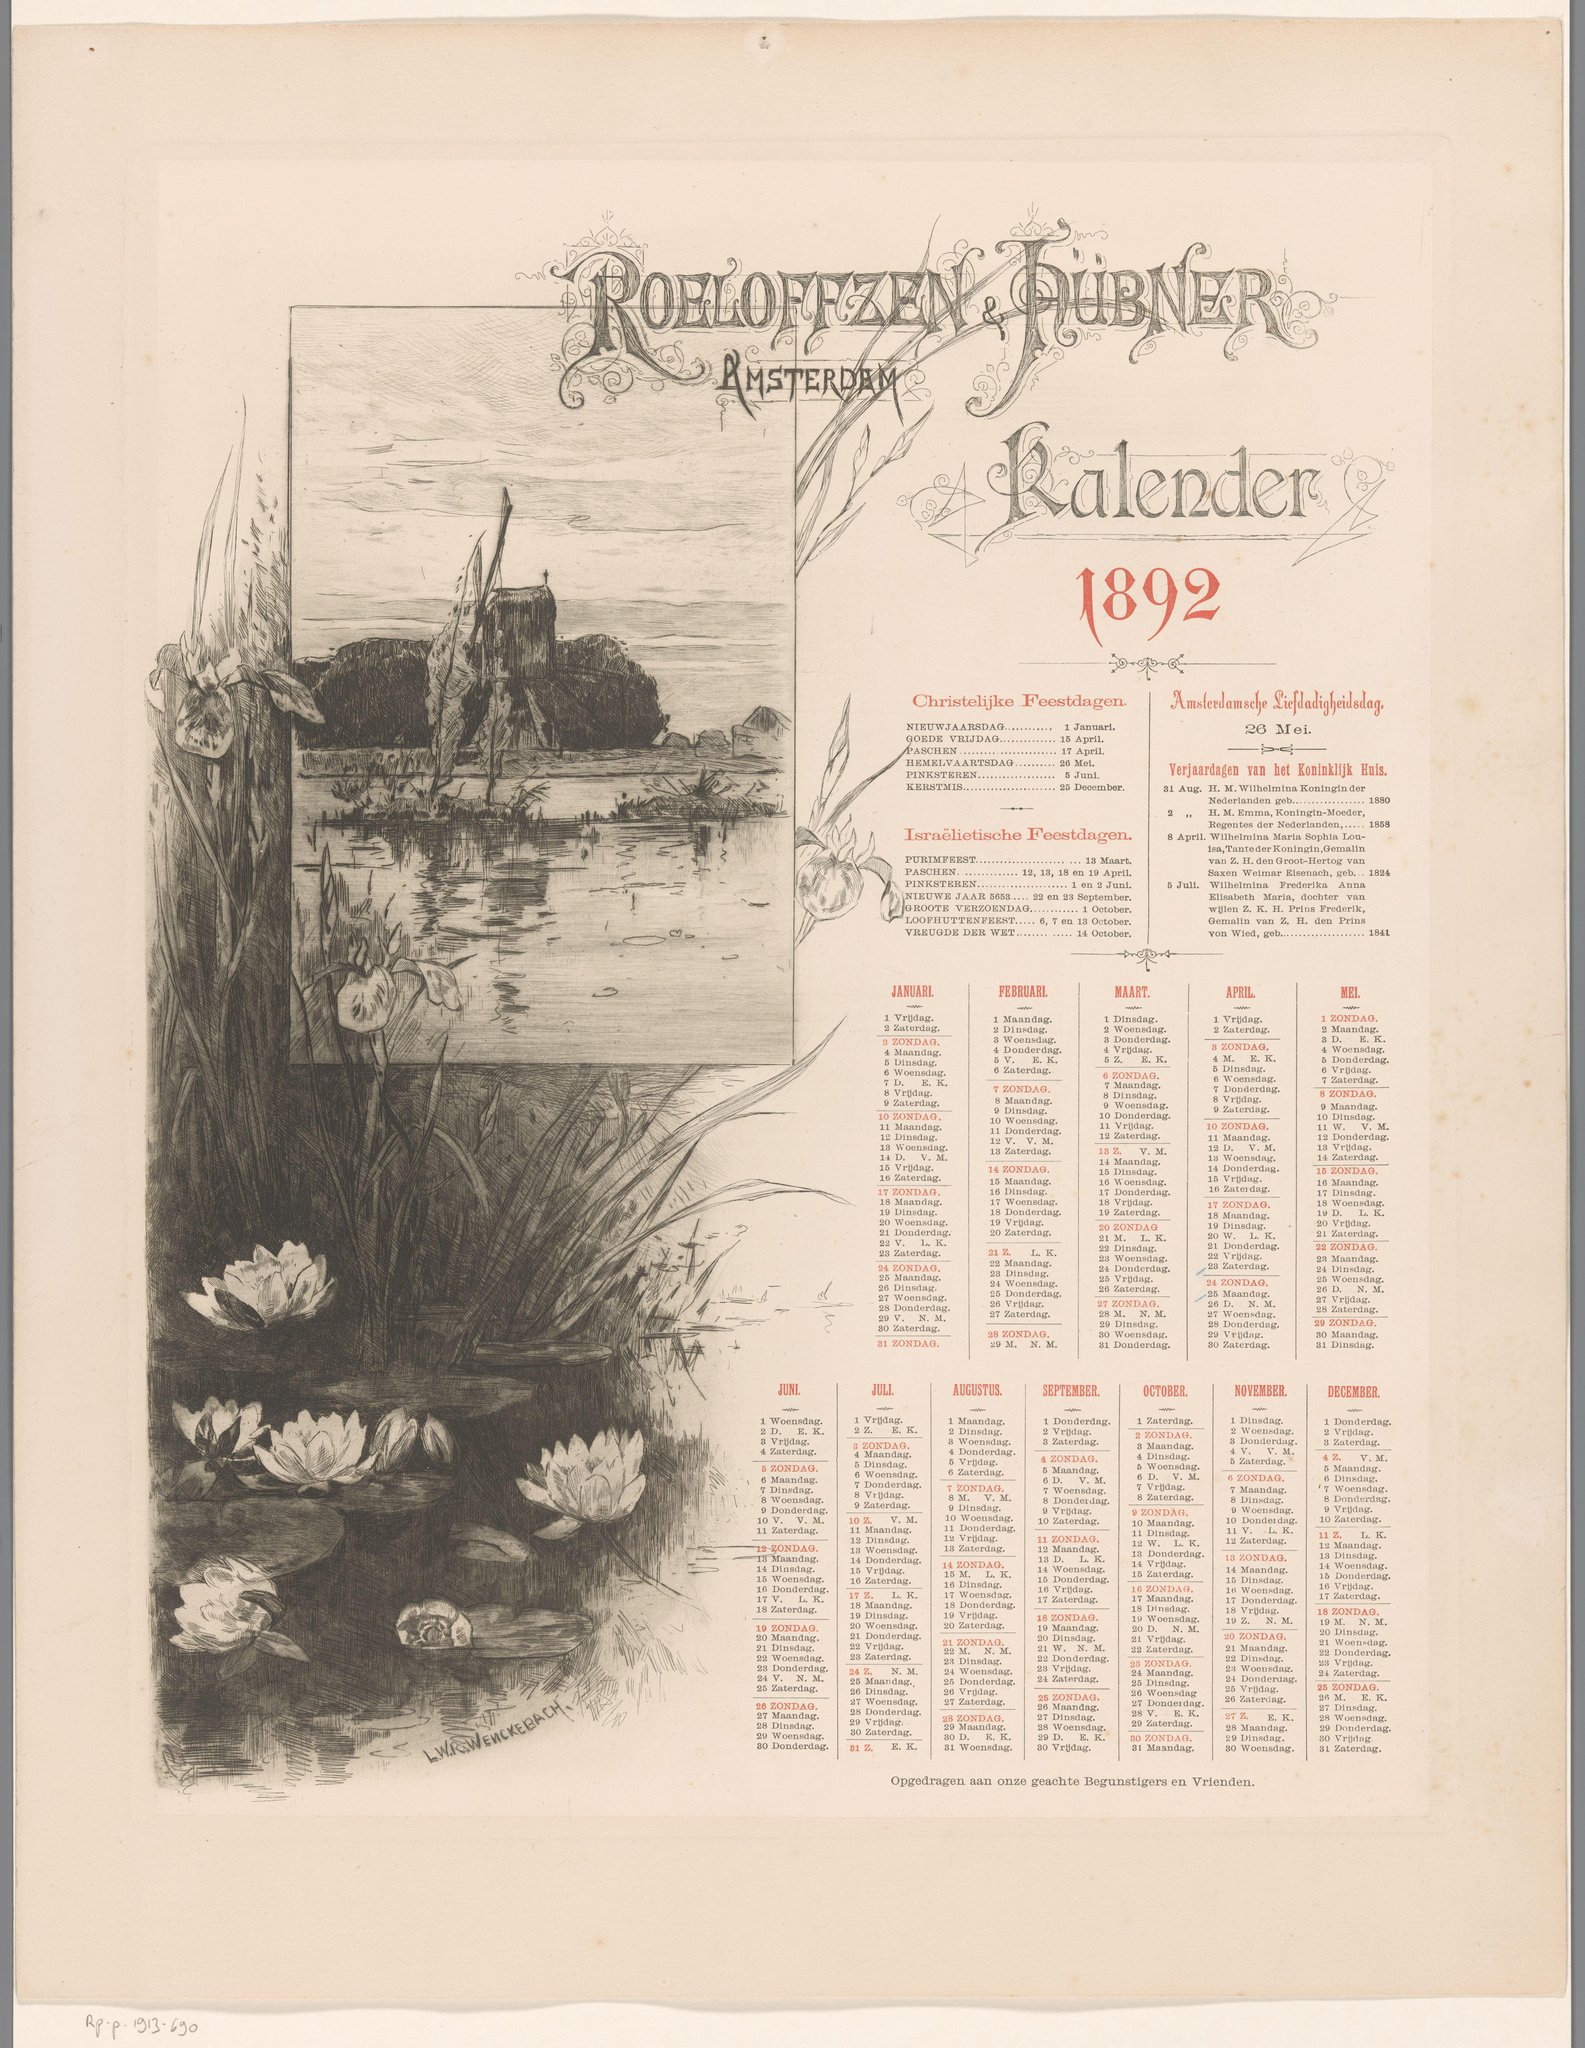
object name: calendar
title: Kalender van drukkerij Roeloffzen & Hübner met molen en waterlelies, 1892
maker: willem wenckebach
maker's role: designer, draughtsman, painter, print maker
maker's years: 1860-1937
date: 1892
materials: paper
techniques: etching, printing, roulette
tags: calendar, almanac, flowers: water-lily, windmill in landscape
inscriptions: collector's mark: Lugt 2233